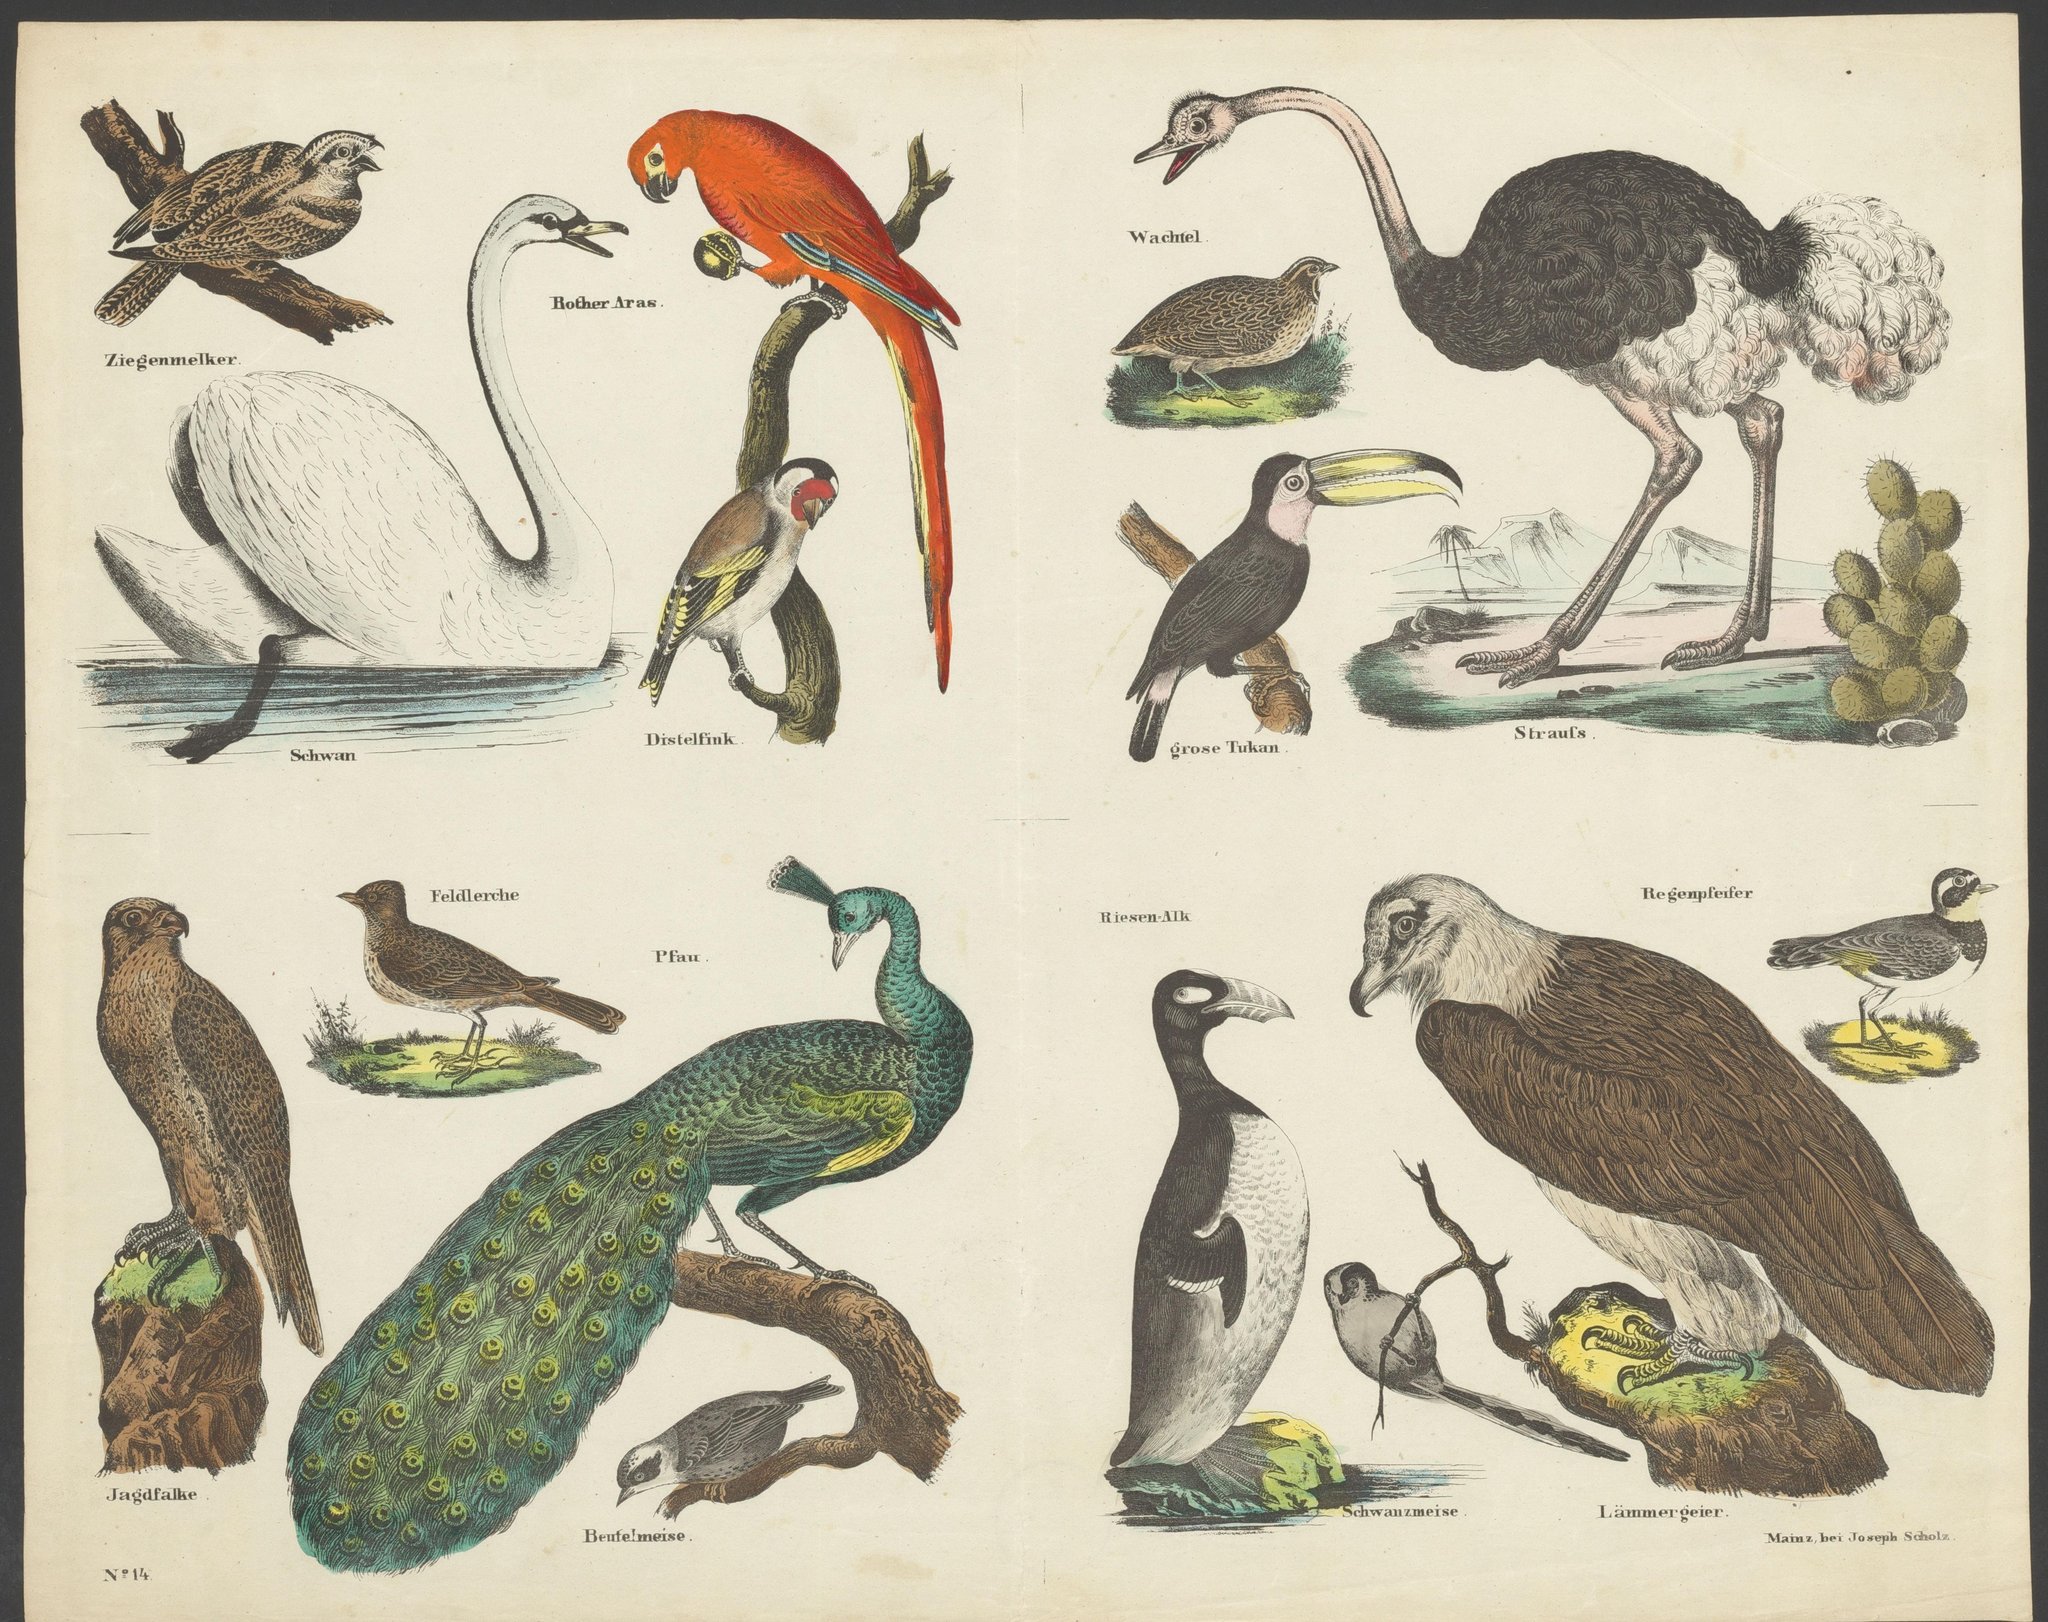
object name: print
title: Diverse vogels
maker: Anonymous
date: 1829-1880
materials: paper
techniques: hand coloring, lithograph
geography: mainz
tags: predatory birds: falcon, walker and runner birds: ostrich, predatory birds: eagle, birds, ornamental birds: peacock, swans (domestic waterbirds)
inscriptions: stamp, collector's mark: Lugt 1641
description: Vijftien voorstellingen van diverse vogels zoals een zwaan, pauw, valk, struisvogel en toekan. Linksonder genummerd: No. 14. Onderwerpsrubrieken binnen de Atlas Zeden en Gewoonten: Zeden en Gewoonten in Engeren Zin, Des menschen beging, midden en einde, Kinderleven – Kinderspel en Kinderprenten.